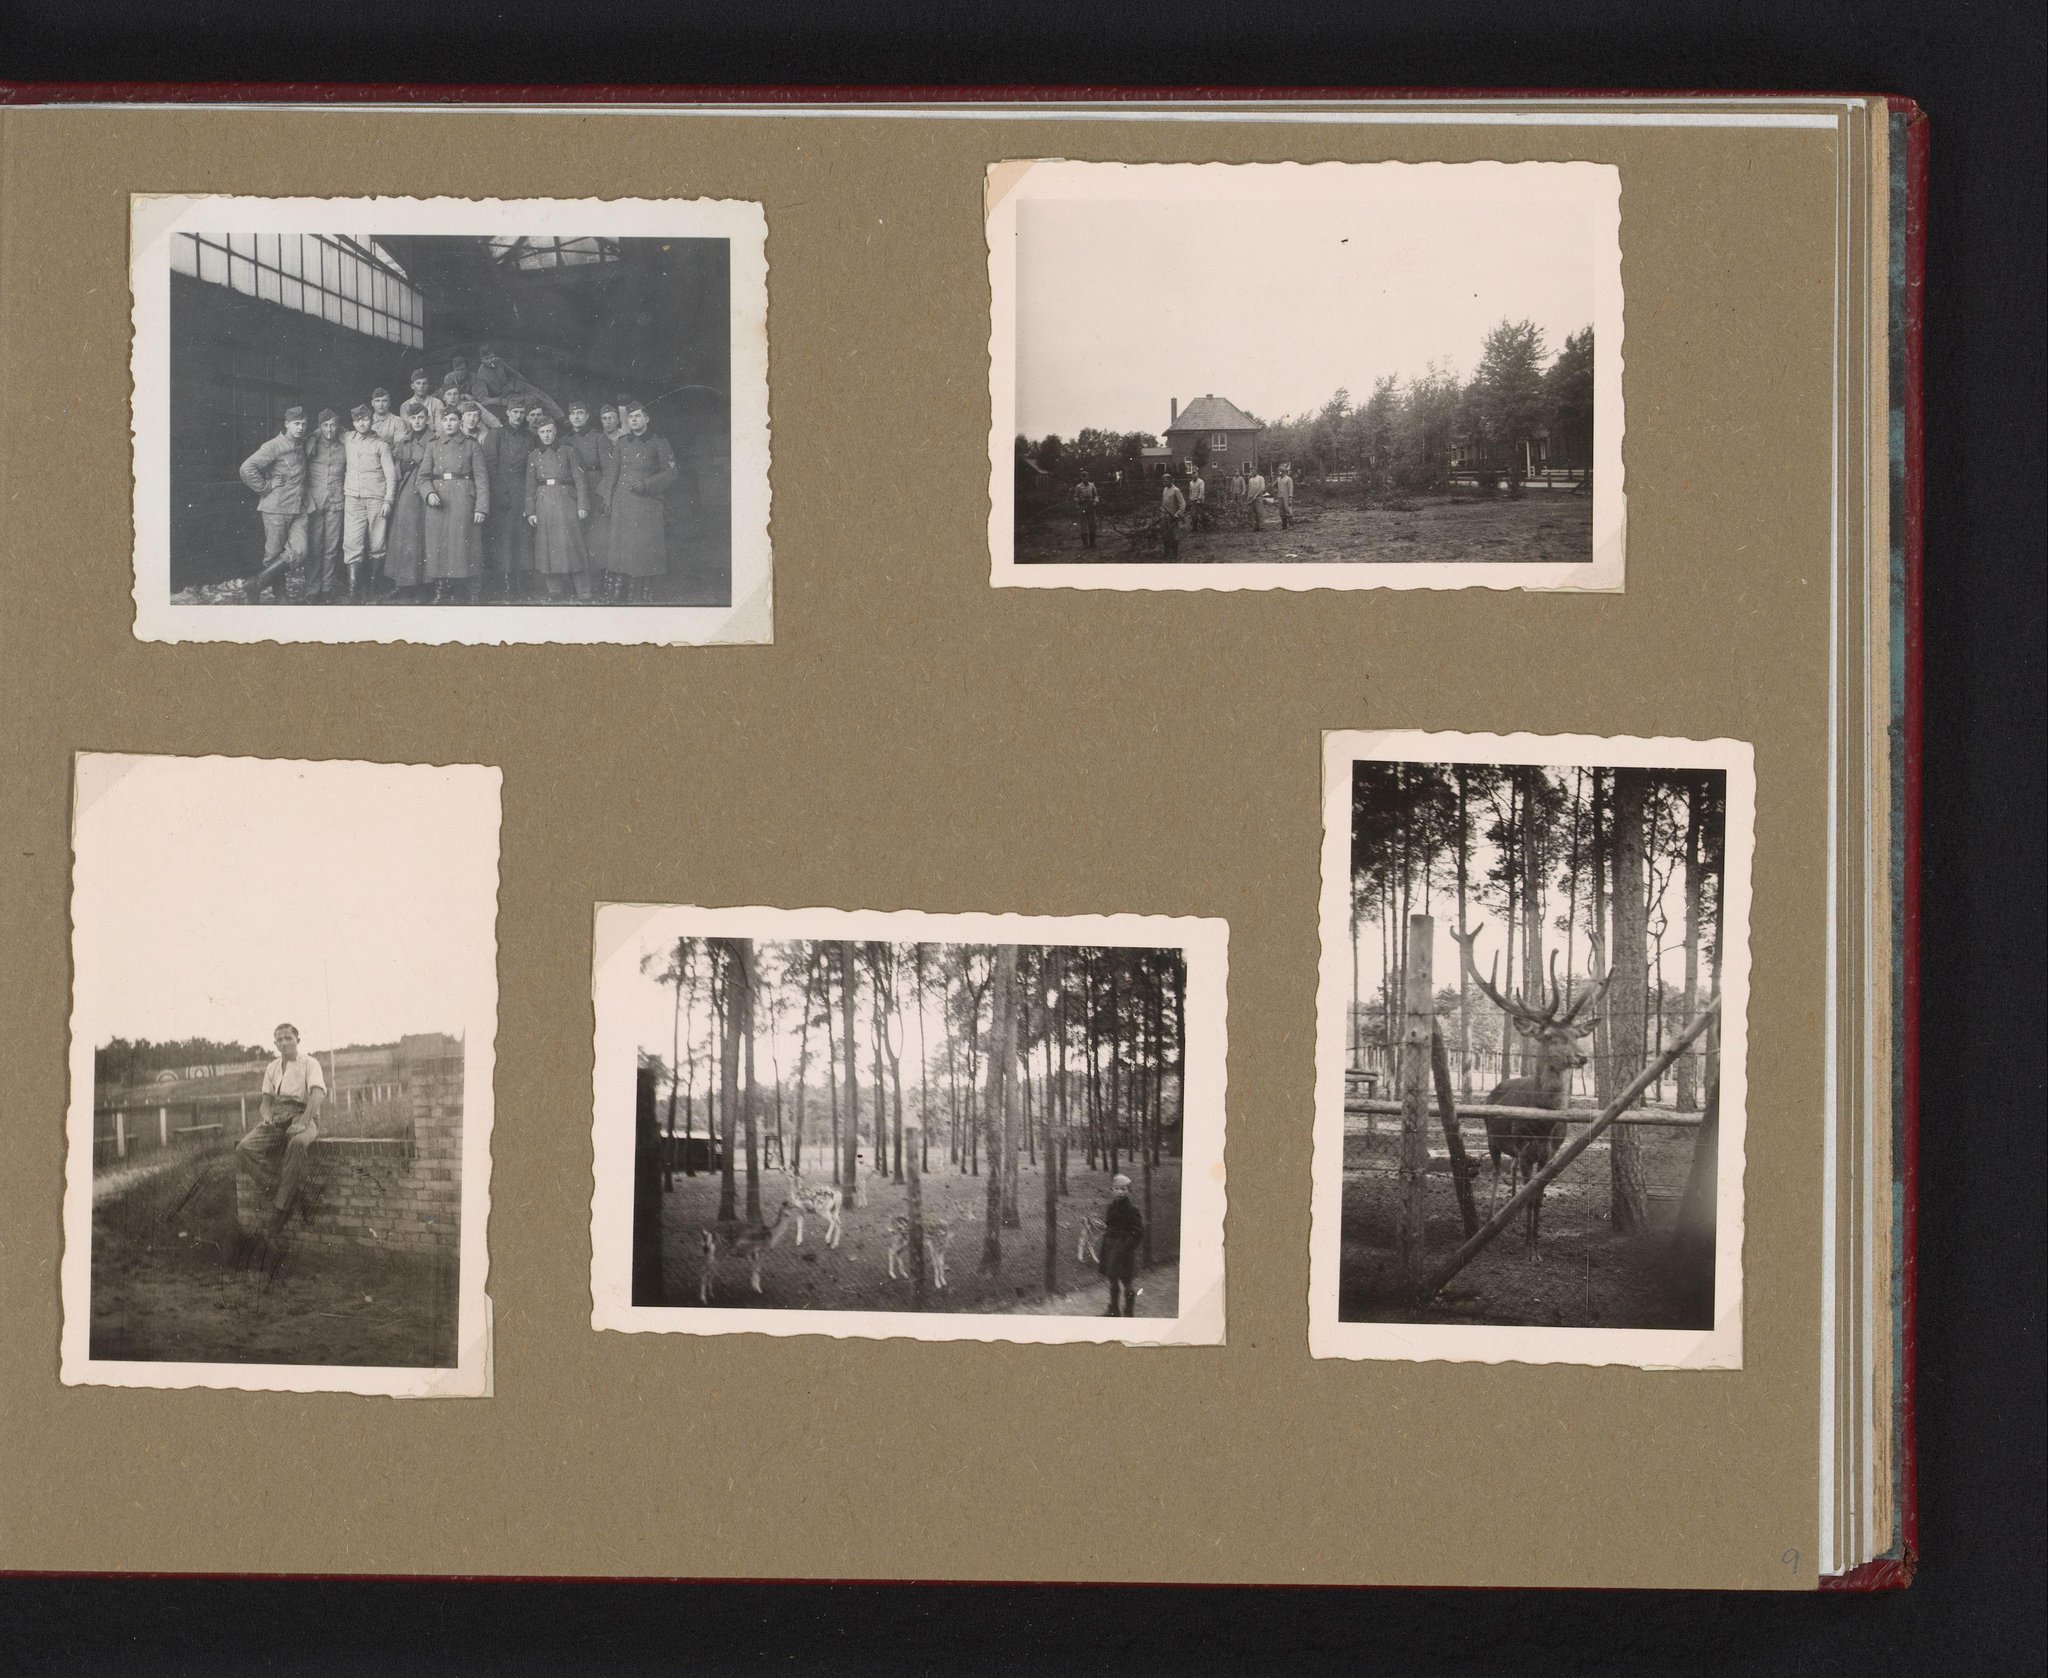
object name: album leaf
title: Diverse onderwerpen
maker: Anonymous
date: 1939-1943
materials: paper, photographic support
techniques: gelatin silver print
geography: apeldoorn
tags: the company, the unit, the troop ~ military service, review, inspection (of company, unit, troop), military training, germany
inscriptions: name: ‘Fotohuis Van Ter Beek’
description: Albumblad met vijf foto's van groepen soldaten tijdens de opleiding en van een hertenkamp in Apeldoorn. Onderdeel van het fotoalbum over soldaten van de Wehrmacht, ca. 1939-1943.